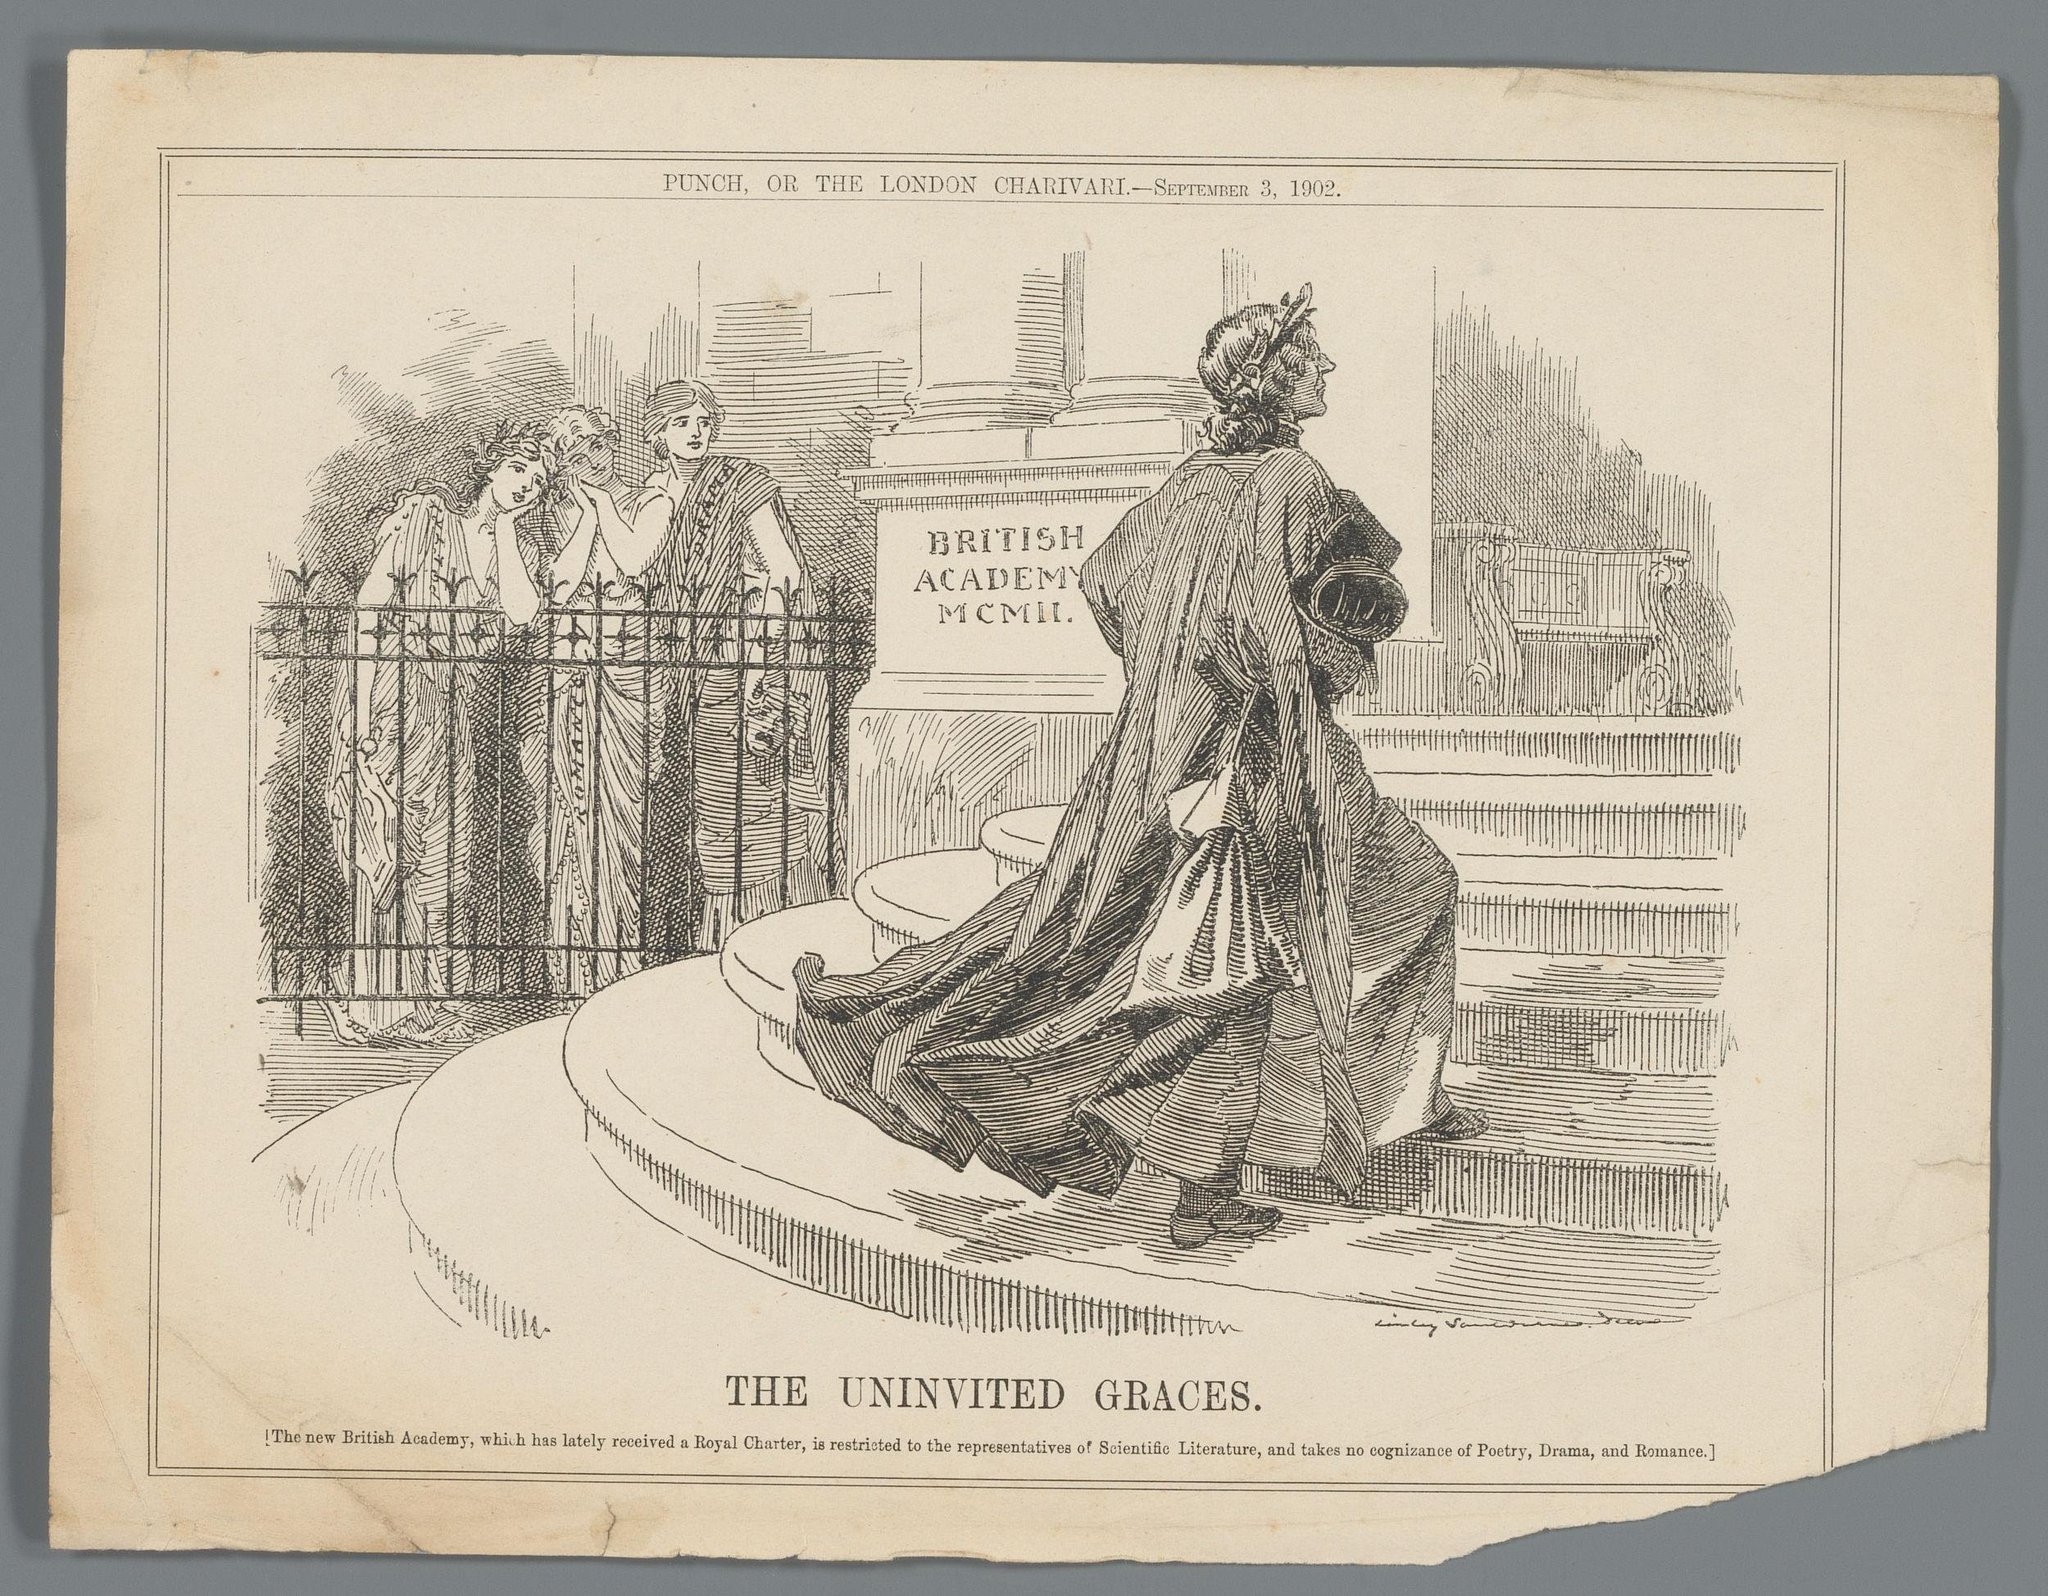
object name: cartoon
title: The uninvited graces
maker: edward linley sambourne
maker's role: draughtsman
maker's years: 1844-1910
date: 1902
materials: paper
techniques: line block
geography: england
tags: symbolic representations, allegories and emblems ~ science, 'scientia'; 'scienza', 'studio' (ripa), graces (charites), generally three in number; 'gratie' (ripa), symbolic representations, allegories and emblems ~ poetry; 'poesia' (ripa), 'tragedia' (ripa), political caricatures and satires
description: De British Academy opgericht in 1902 maakt bekend alleen wetenschappelijke literatuur te zullen toelaten en negeert hiermee de Poëzie, Drama en Romankunst. Spotprent uit het Engelse satirische tijdschrift Punch, 3 september 1902.